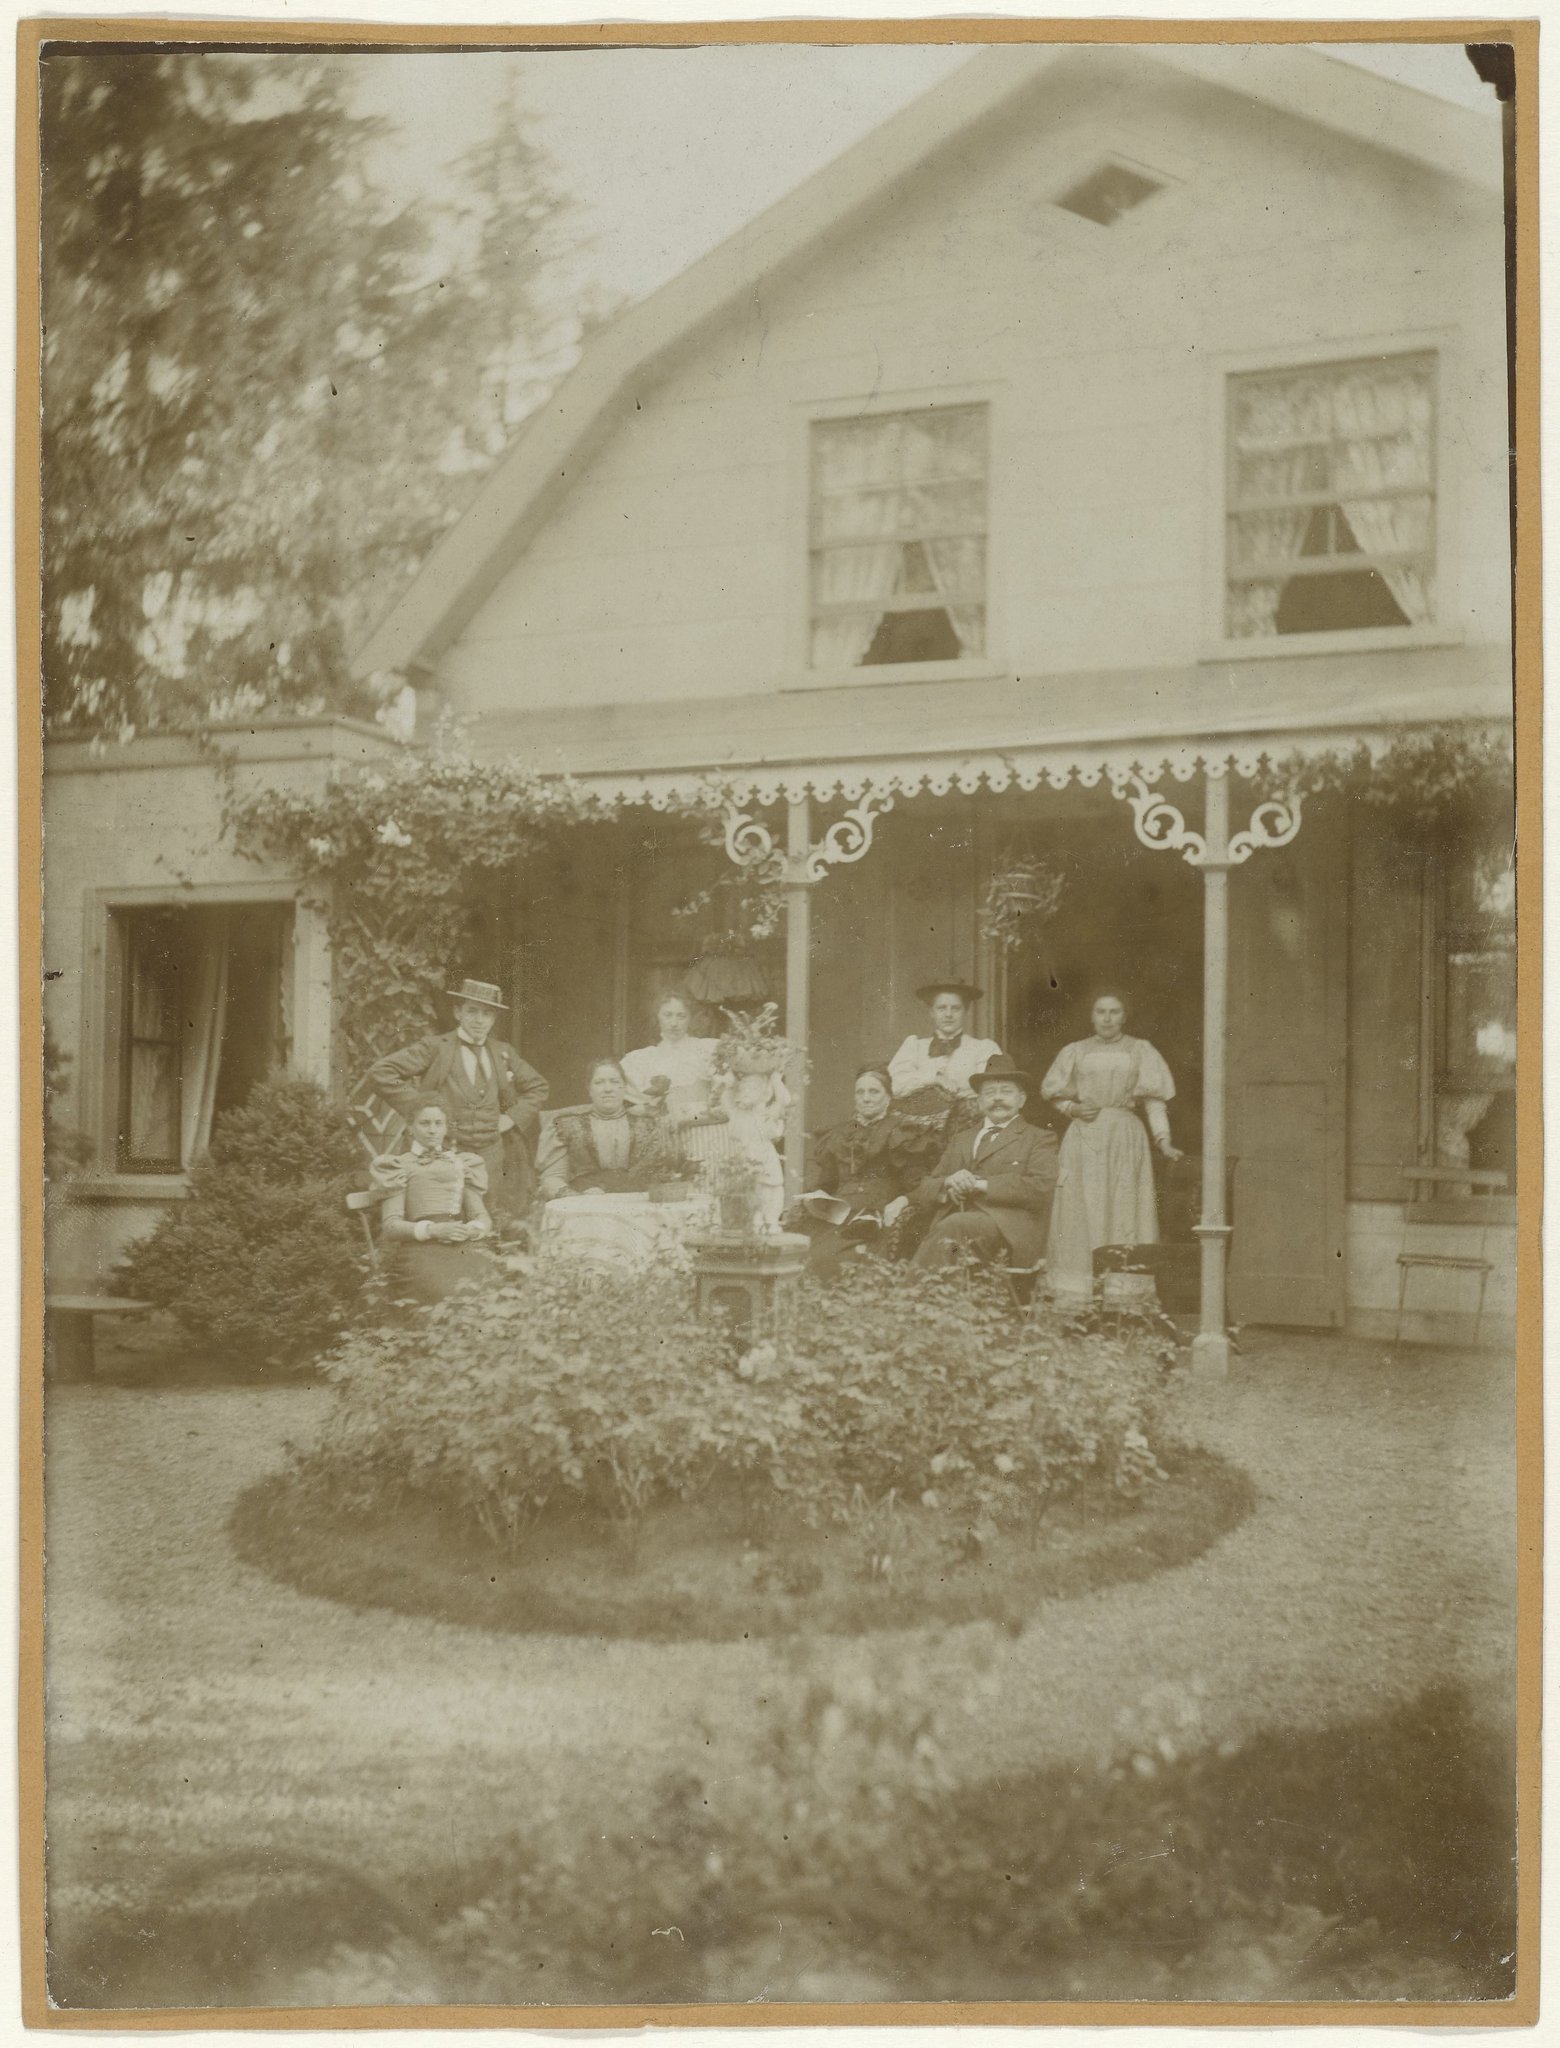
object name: photograph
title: Familieportret voor Huis te Vraag in Amsterdam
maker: Anonymous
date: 1880-1920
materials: cardboard, photographic support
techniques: collodion silver print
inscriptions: inscription: ‘Huis de Vraag, Sloterweg inmiddels gesloopt. Willen II vrieg hier de weg naar Amsterdam vandaar huis de Vraag’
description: Huis te Vraag is in 1890 gesloopt thans ligt hier een begraafplaats met dezelfdee naam, de Sloterweg in Rijnsburgstraat geworden.